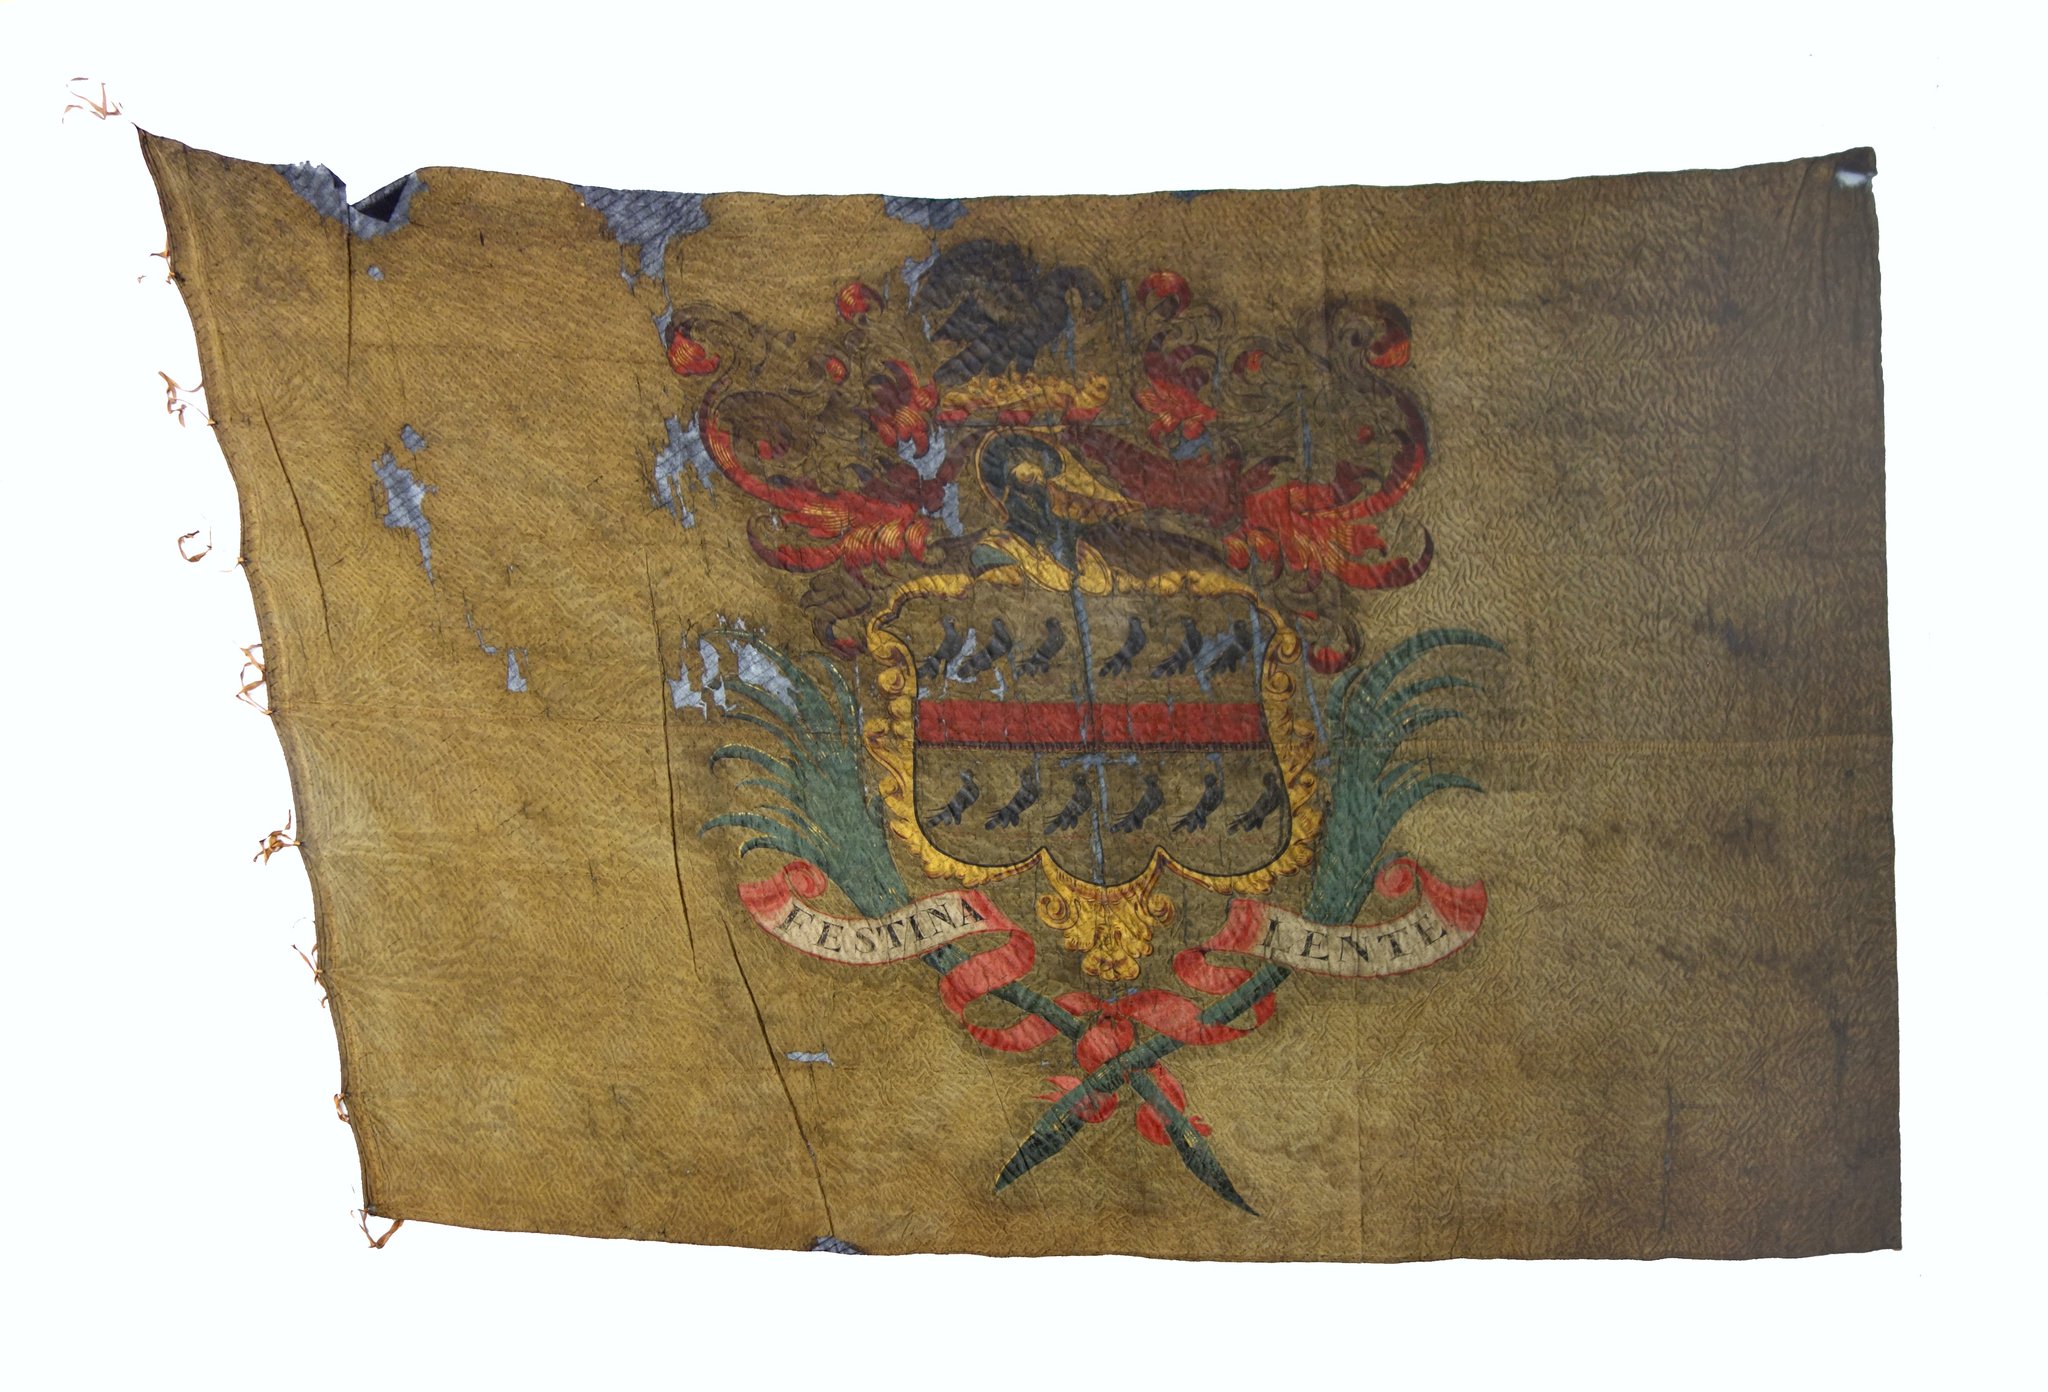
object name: banner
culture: british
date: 1767-1800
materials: silk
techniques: polychromy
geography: united kingdom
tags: coat of arms